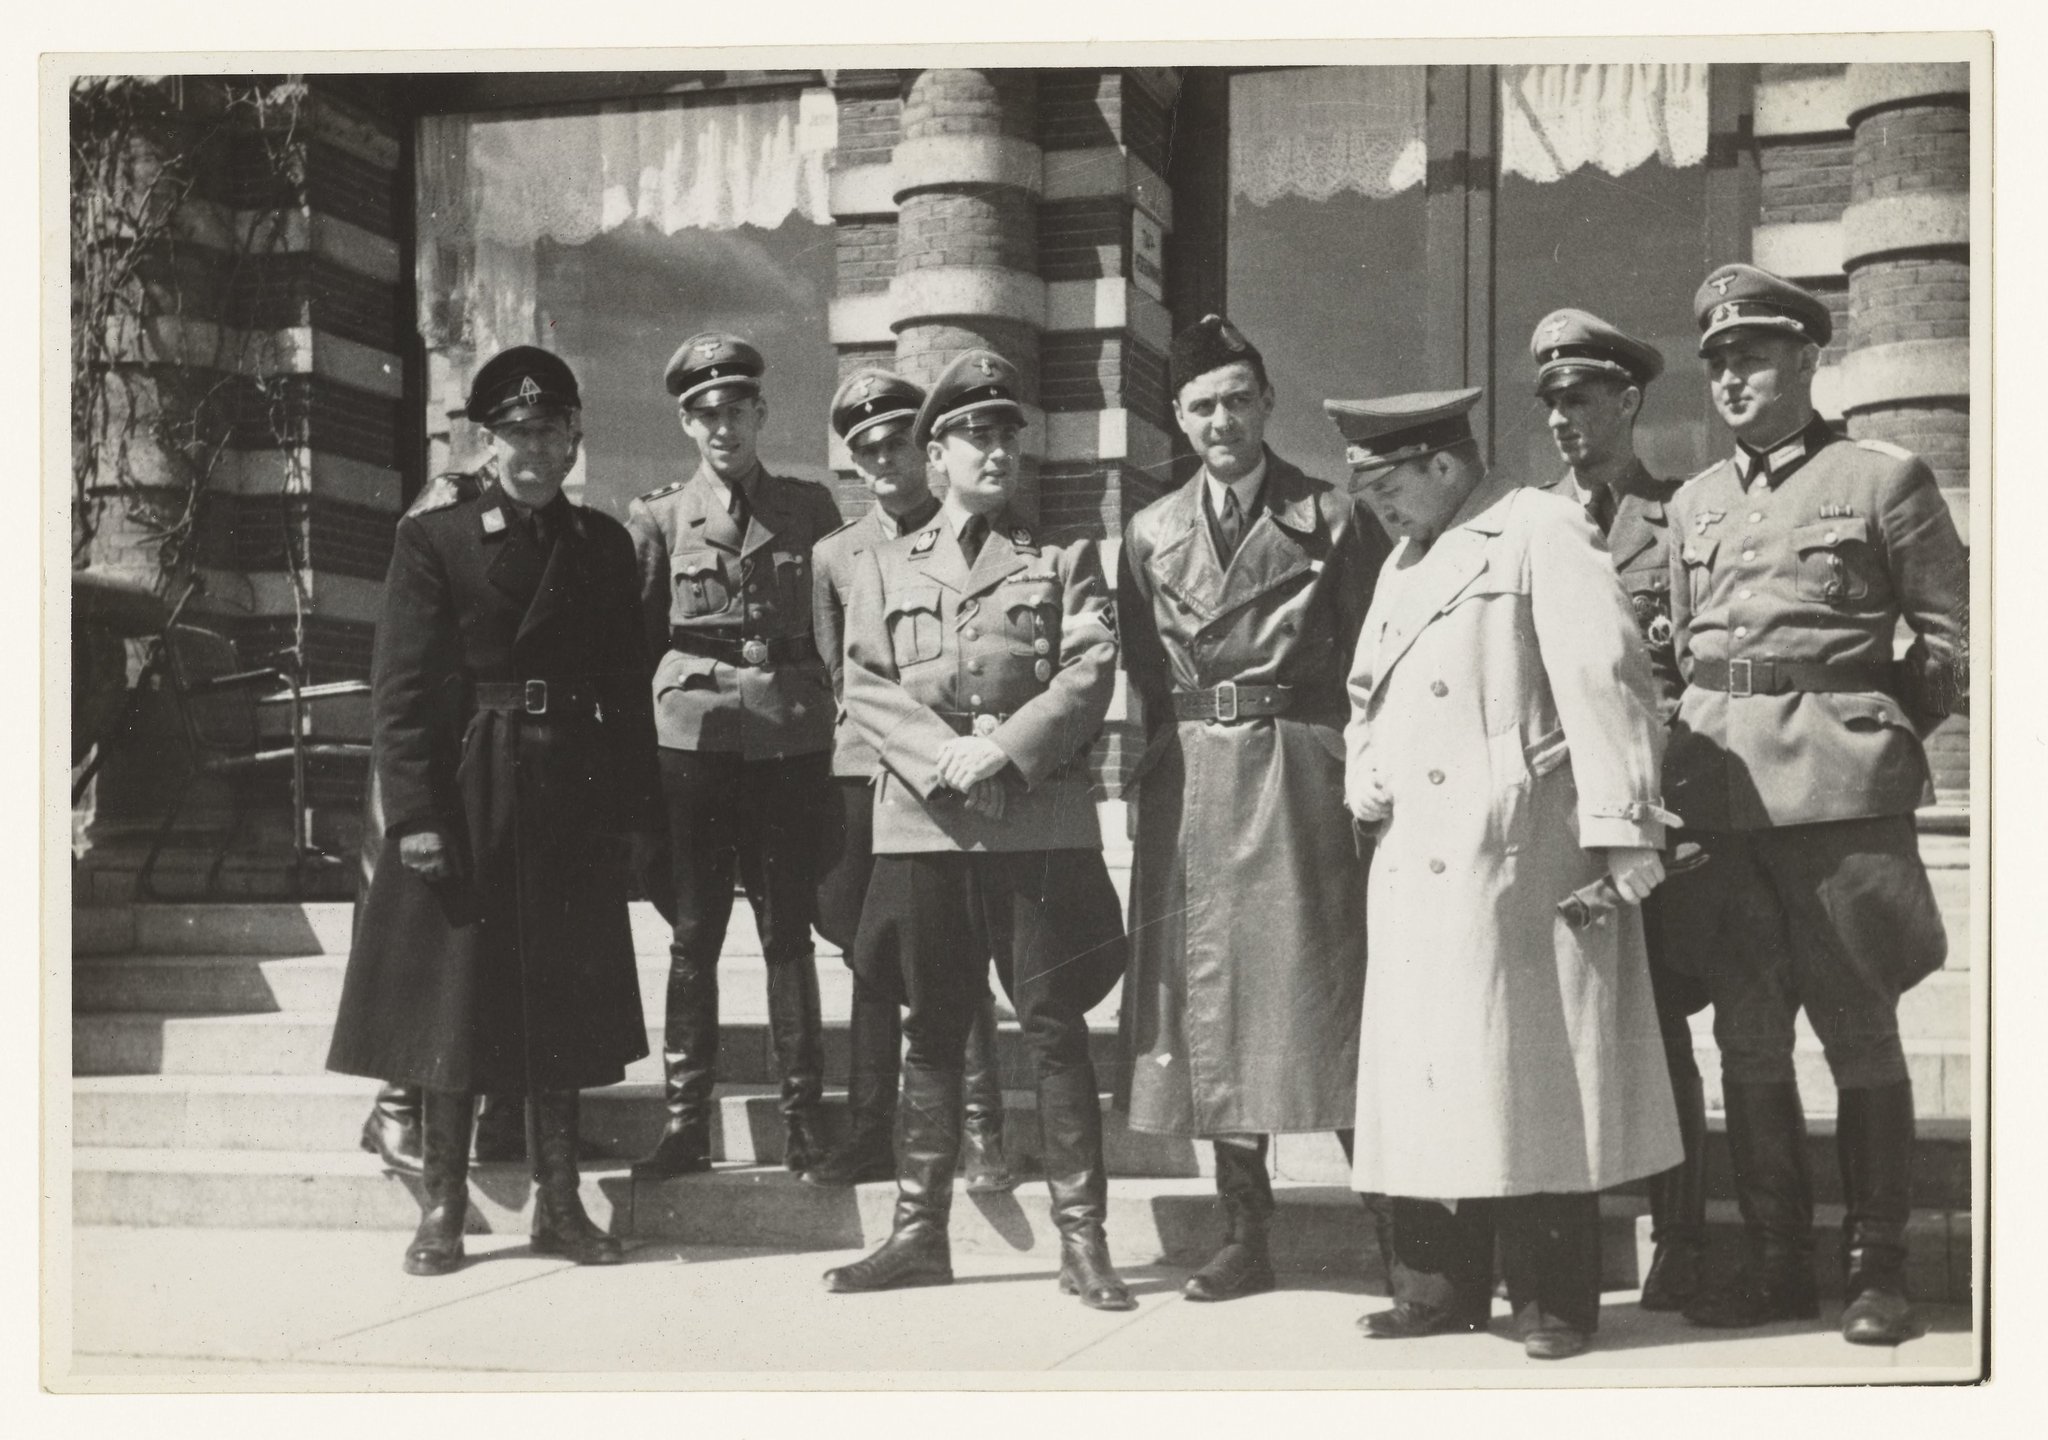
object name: photograph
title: Axmann en Van Geelkerken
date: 1942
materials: photographic support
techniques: photography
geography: the hague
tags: belgium, official, political meeting, propaganda meeting, the hague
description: Arthur Axmann, Reichsjugendführer, en Van Geelkerken, leider ven de Jeugdstorm samen met andere hooggeplaatste Duitsers en NSBers op de stoep van kasteel Oud-Wassenaar. Links in lange zwarte jas WA Heerbanleider Meulenberg en rechts in lichte jas, Fritz Schmidt. Schmidt commissaris-generaal van Seyss-Inquart en Hauptdienstleiter van de NSDAP kwam op 27 juni 1943 om het leven.